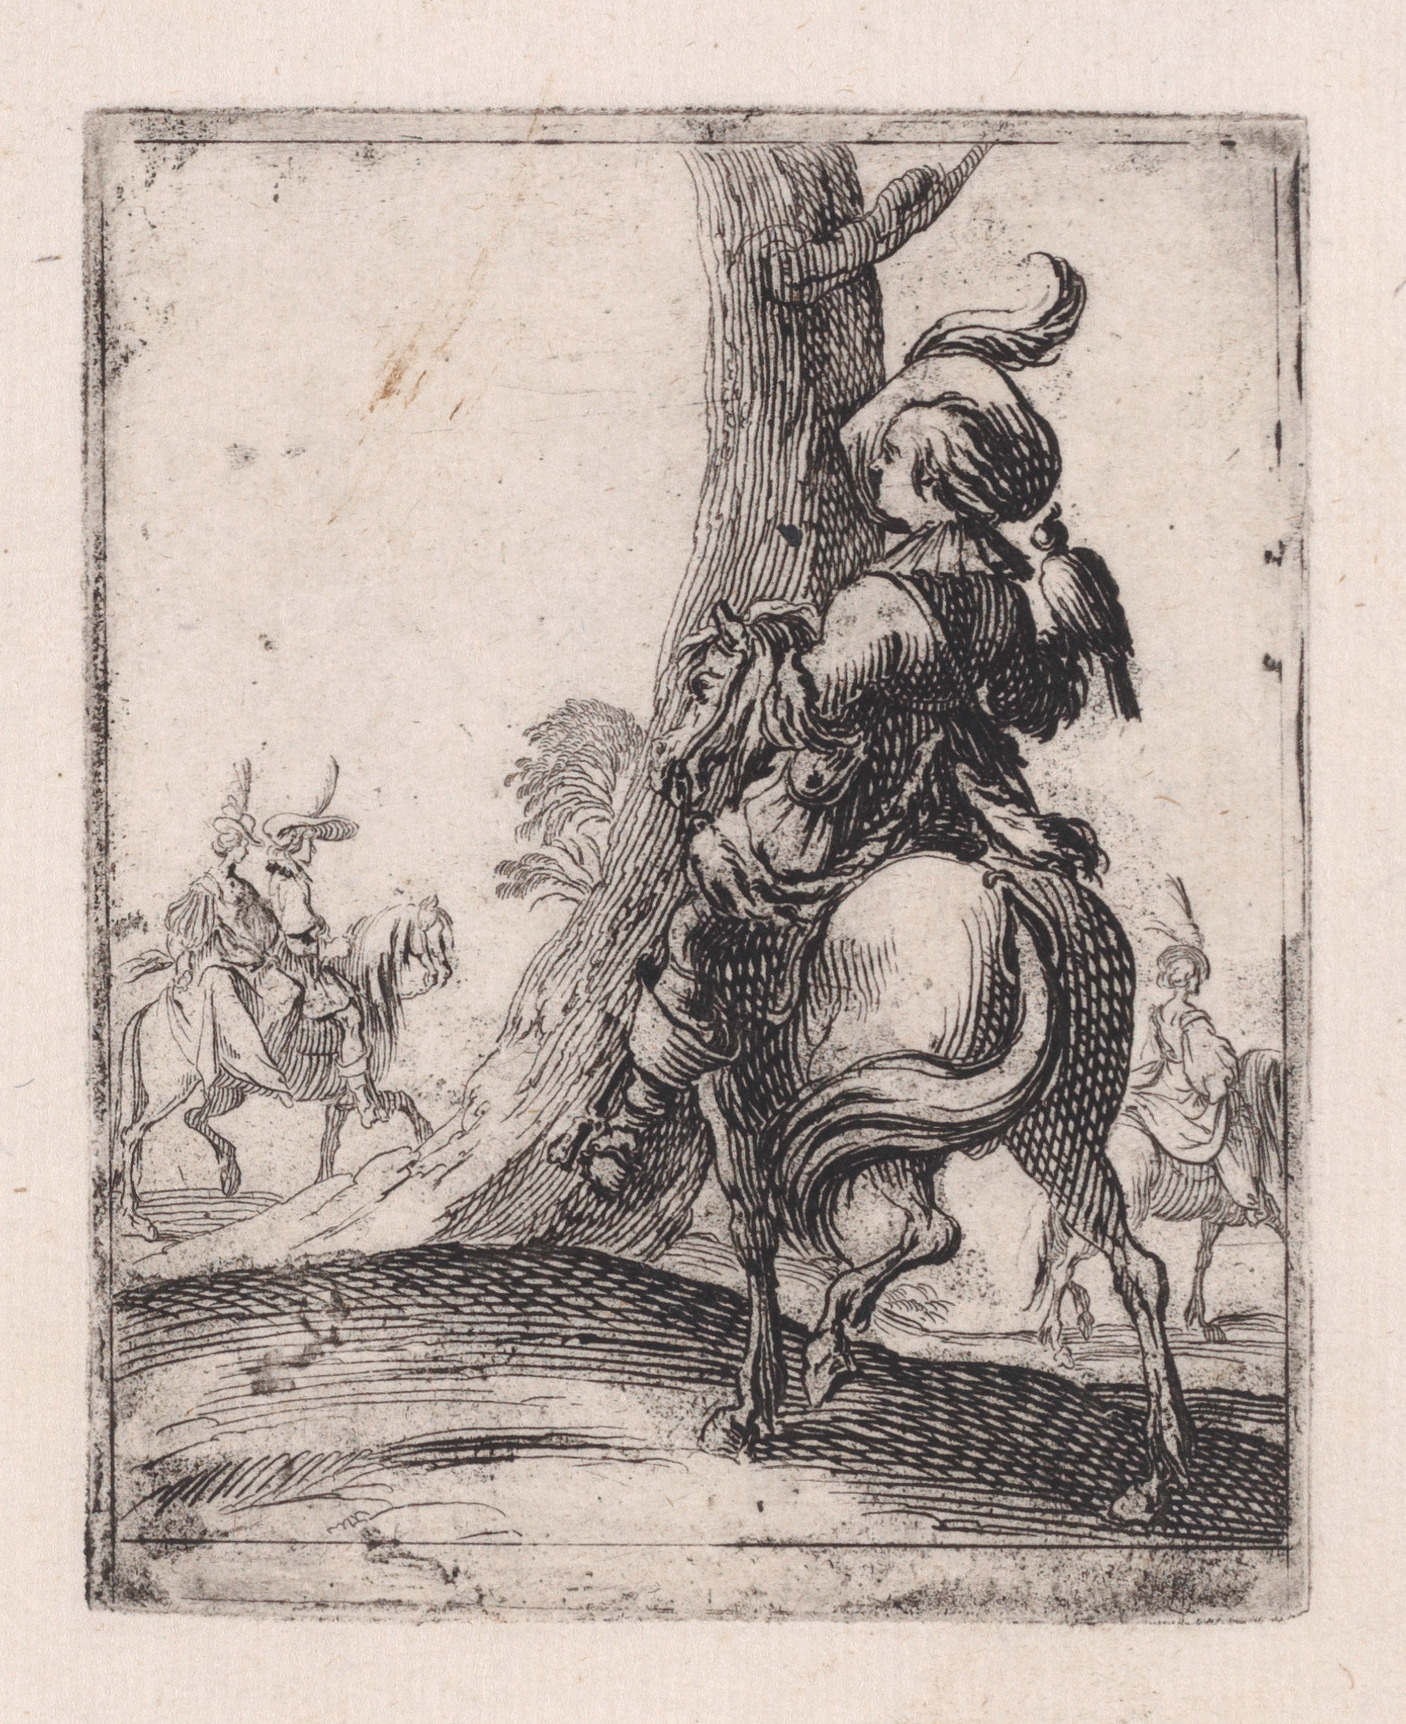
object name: print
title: The Falconer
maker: jacques callot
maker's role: artist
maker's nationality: french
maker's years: 1592-1635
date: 1617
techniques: etching